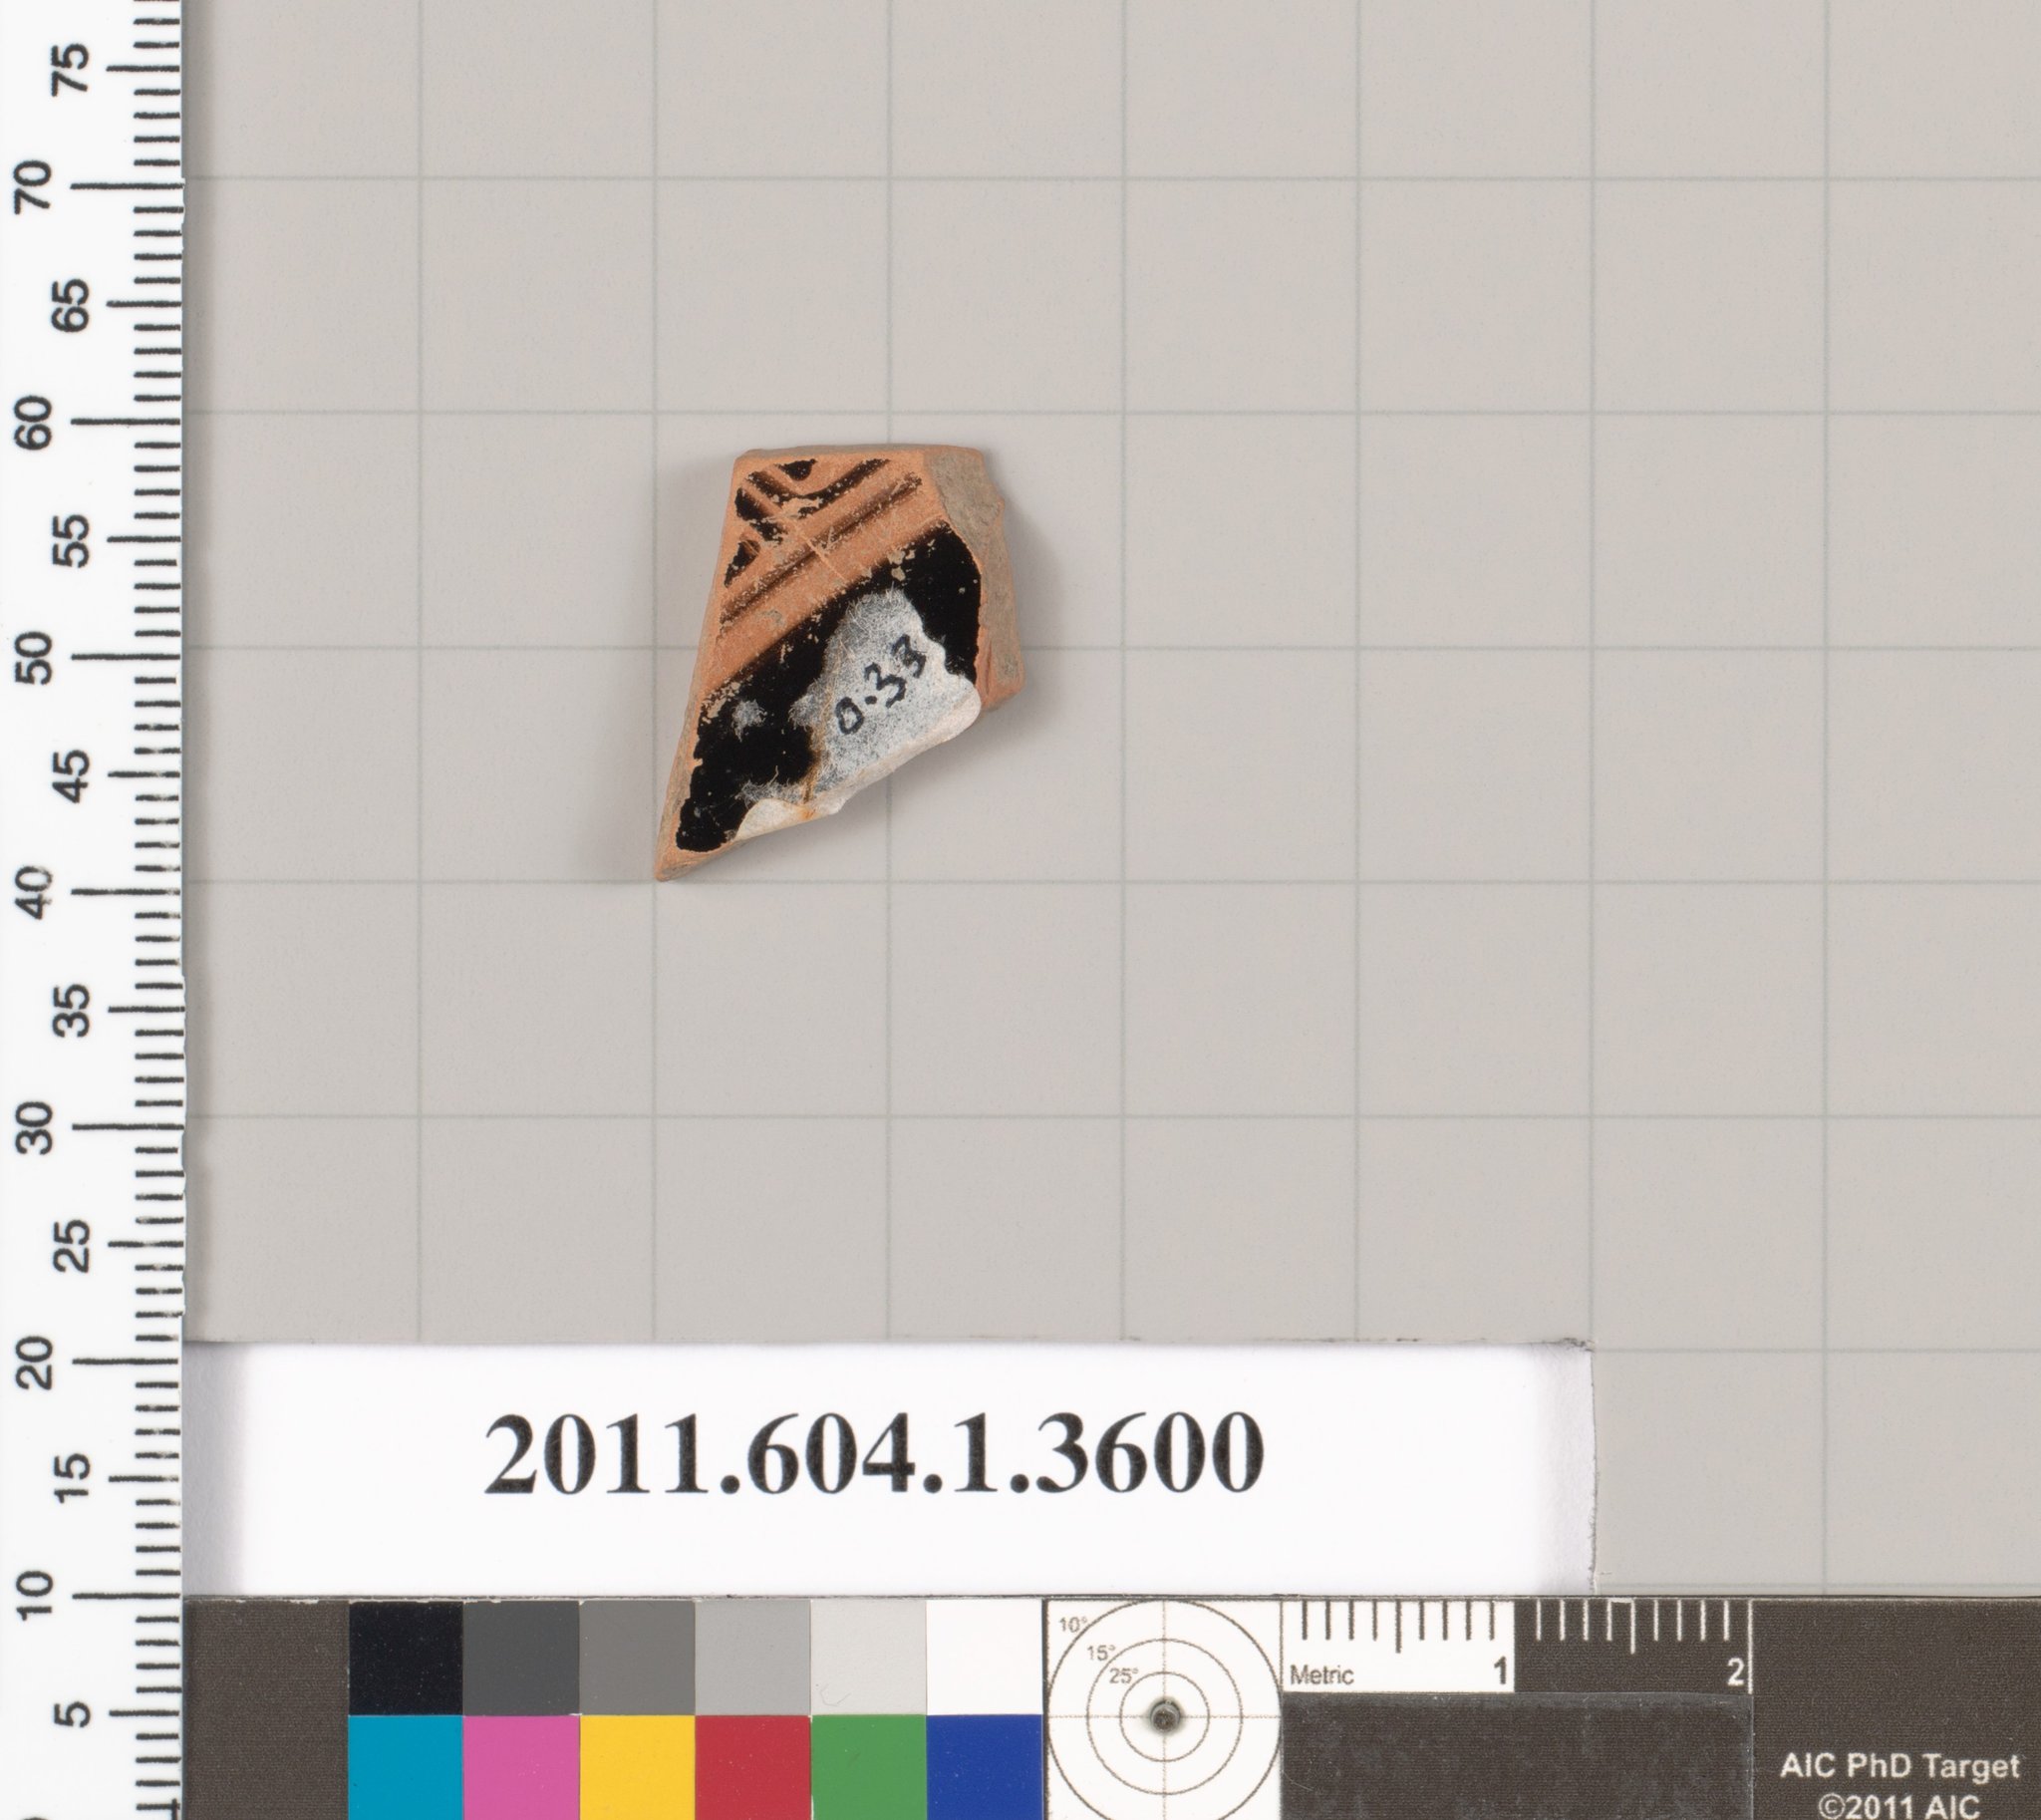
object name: kylix fragment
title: Terracotta fragment of a kylix (drinking cup)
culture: greek, attic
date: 500-476 BCE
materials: terracotta